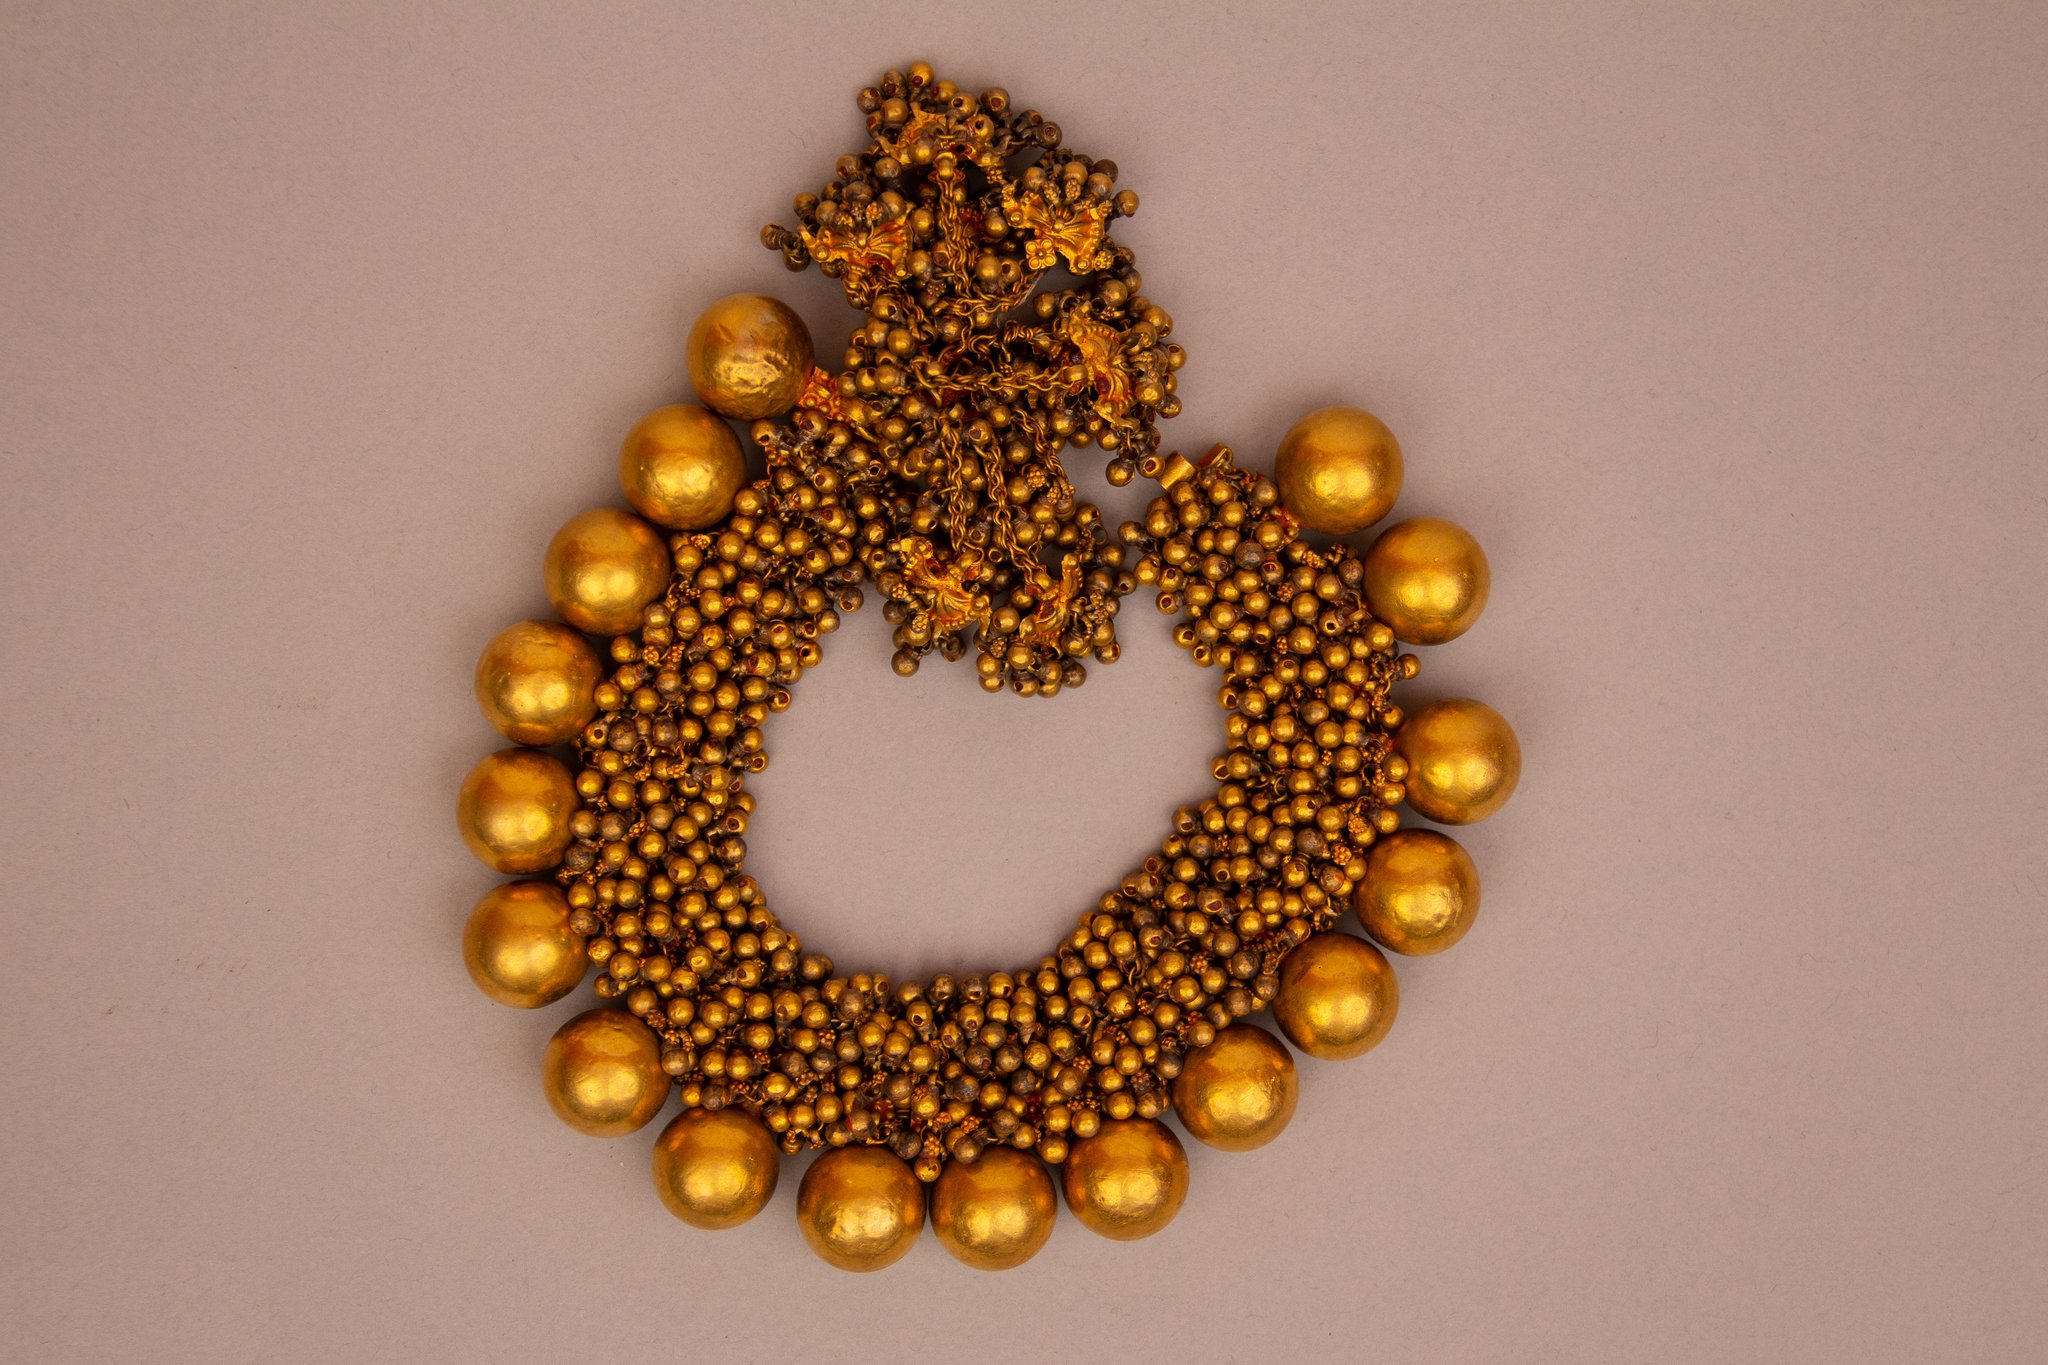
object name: anklet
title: Anklet, One of a Pair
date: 1801-1900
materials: gold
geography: india